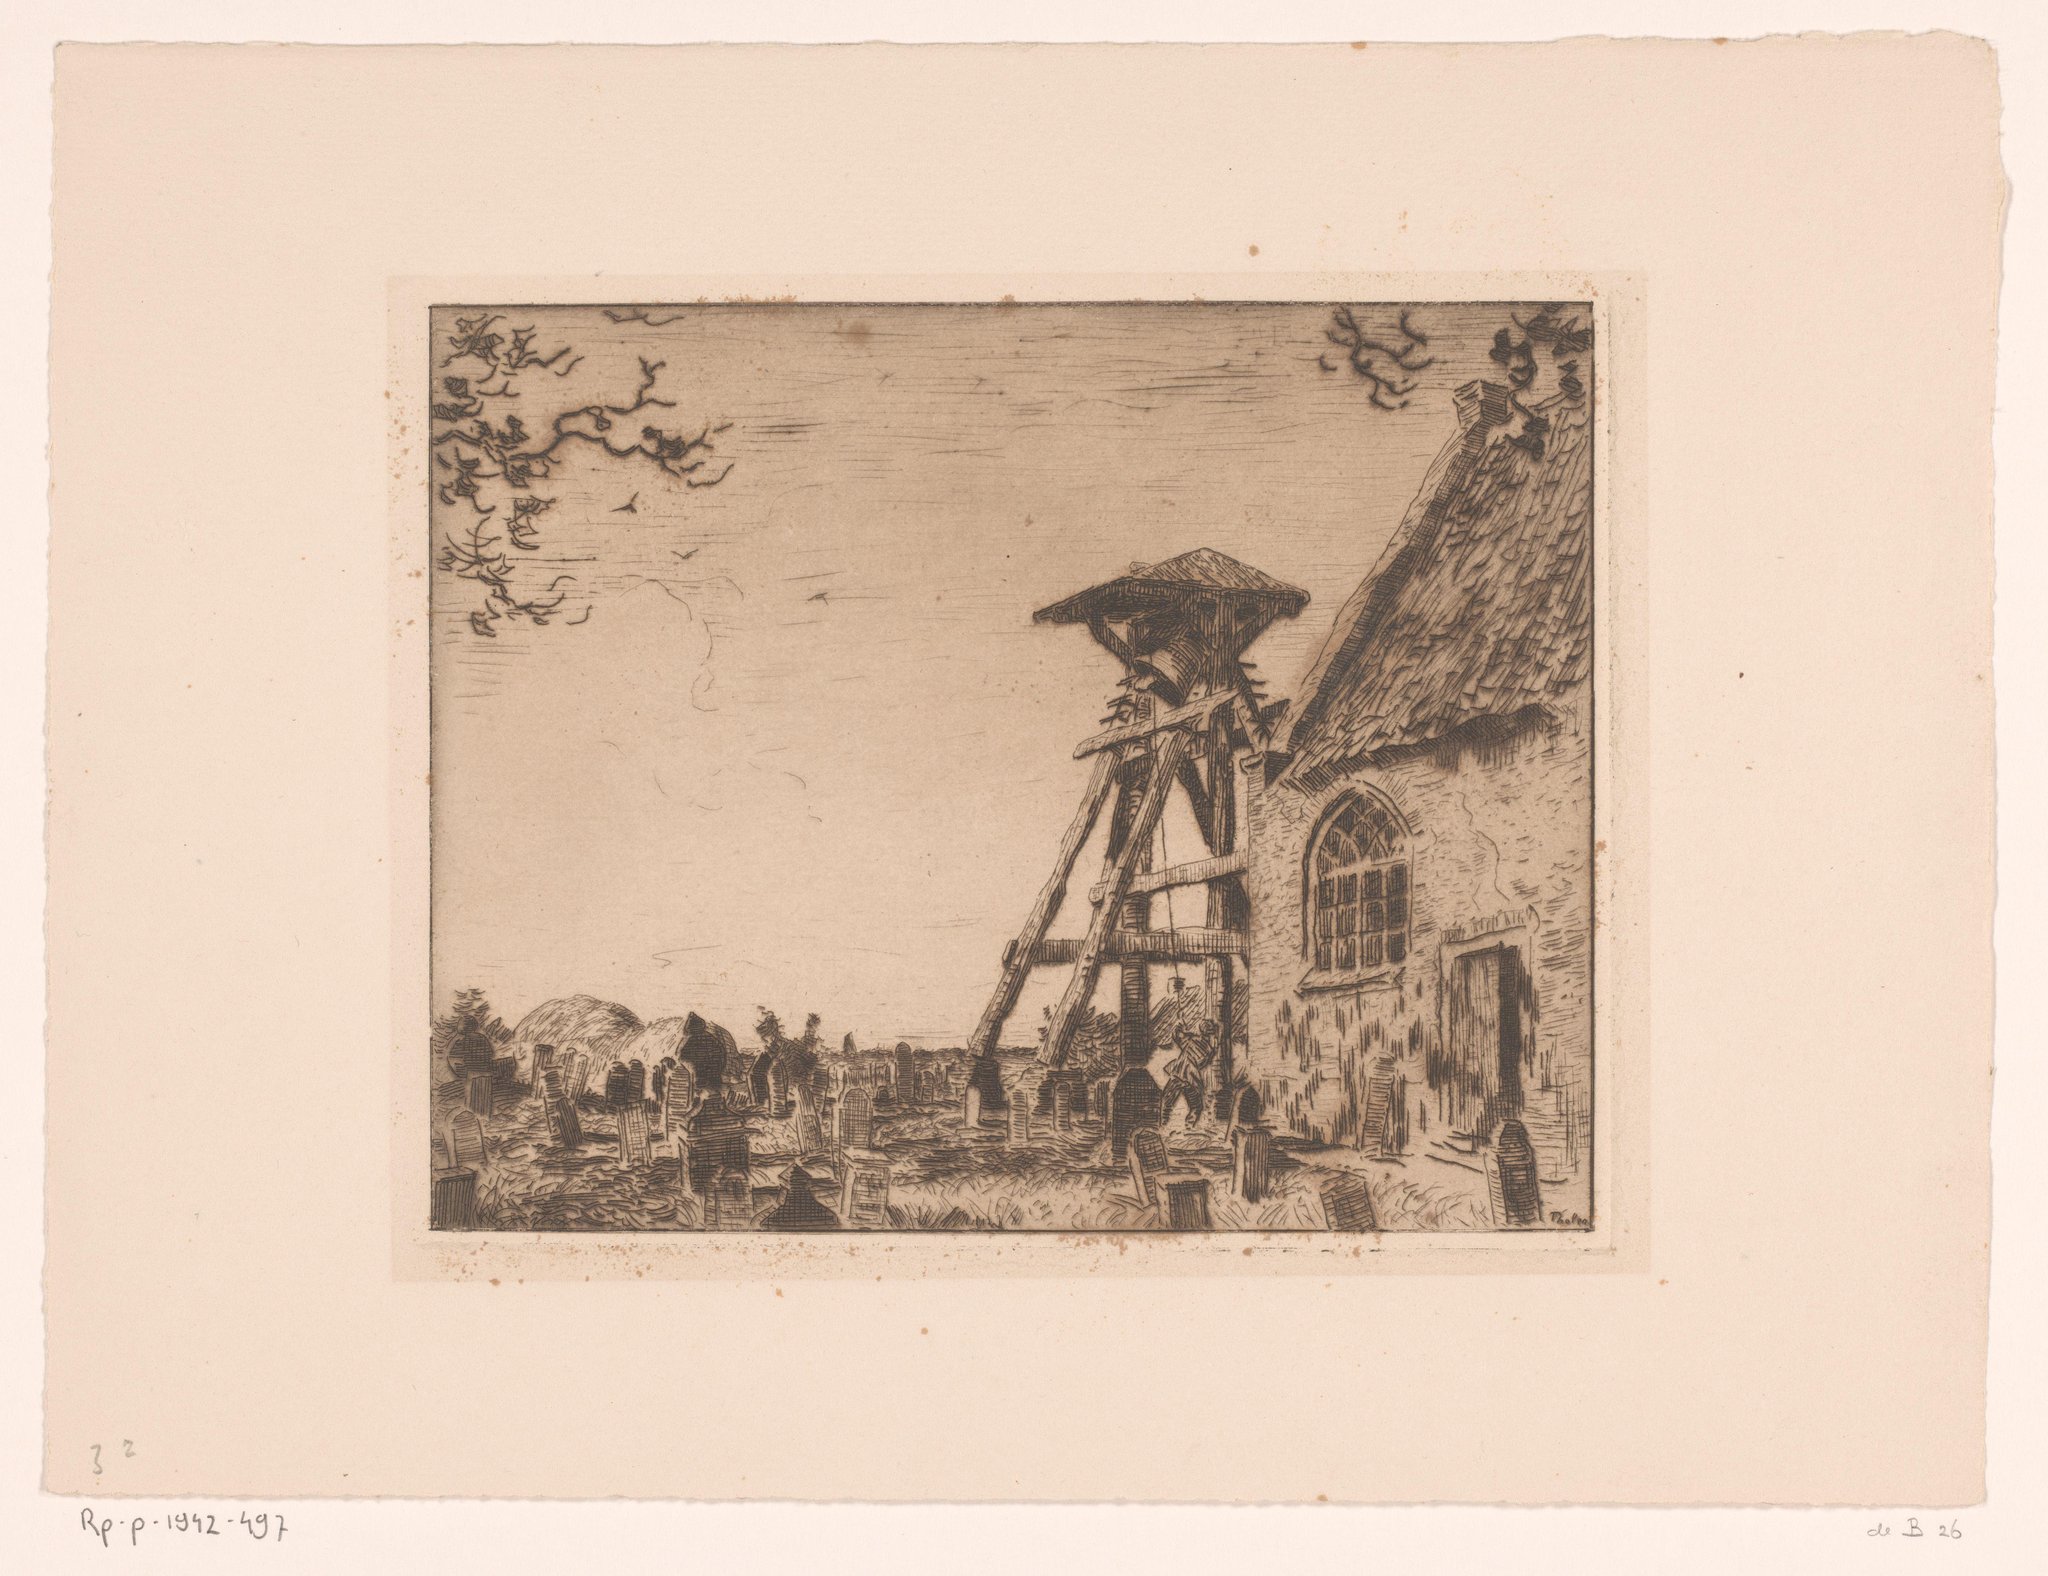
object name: print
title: Kerk met kerkhof en klokkenstoel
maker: willem bastiaan tholen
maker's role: draughtsman, painter, print maker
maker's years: 1860-1931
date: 1870-1908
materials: paper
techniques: etching, intaglio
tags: church (exterior), church bell, churchyard, cemetery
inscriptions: collector's mark: Lugt 2228